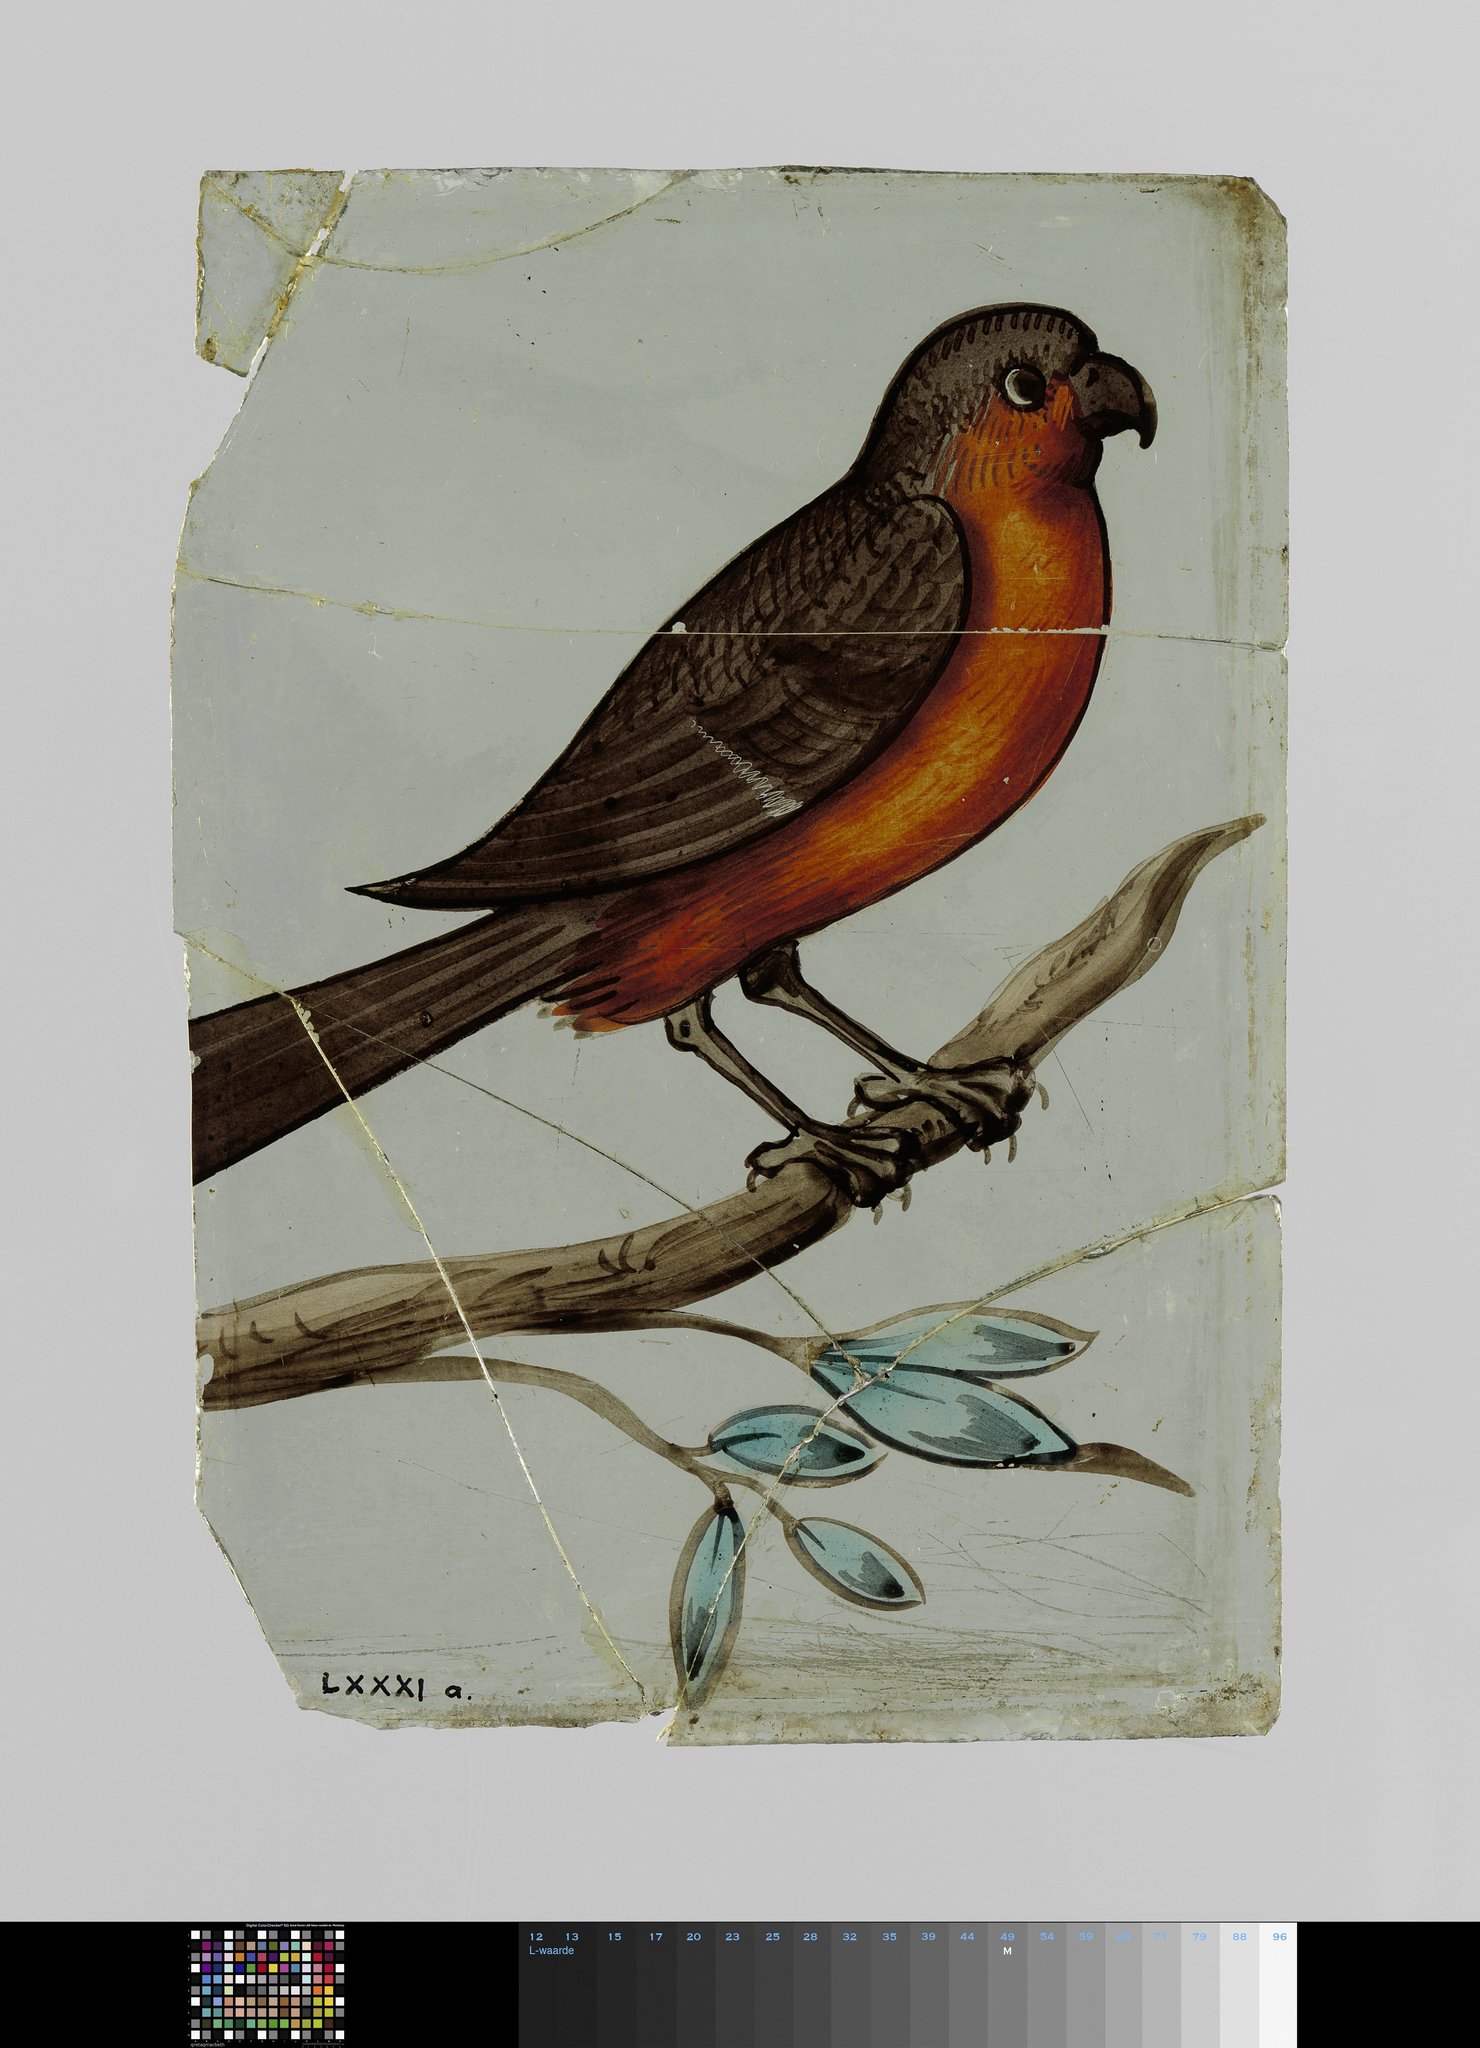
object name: light window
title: Ruit met een vogel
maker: Anonymous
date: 1650-1675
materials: glass, lead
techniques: enamel painting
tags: birds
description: Ruit met emailschildering van een vogel in voornamelijk rood en bruin.